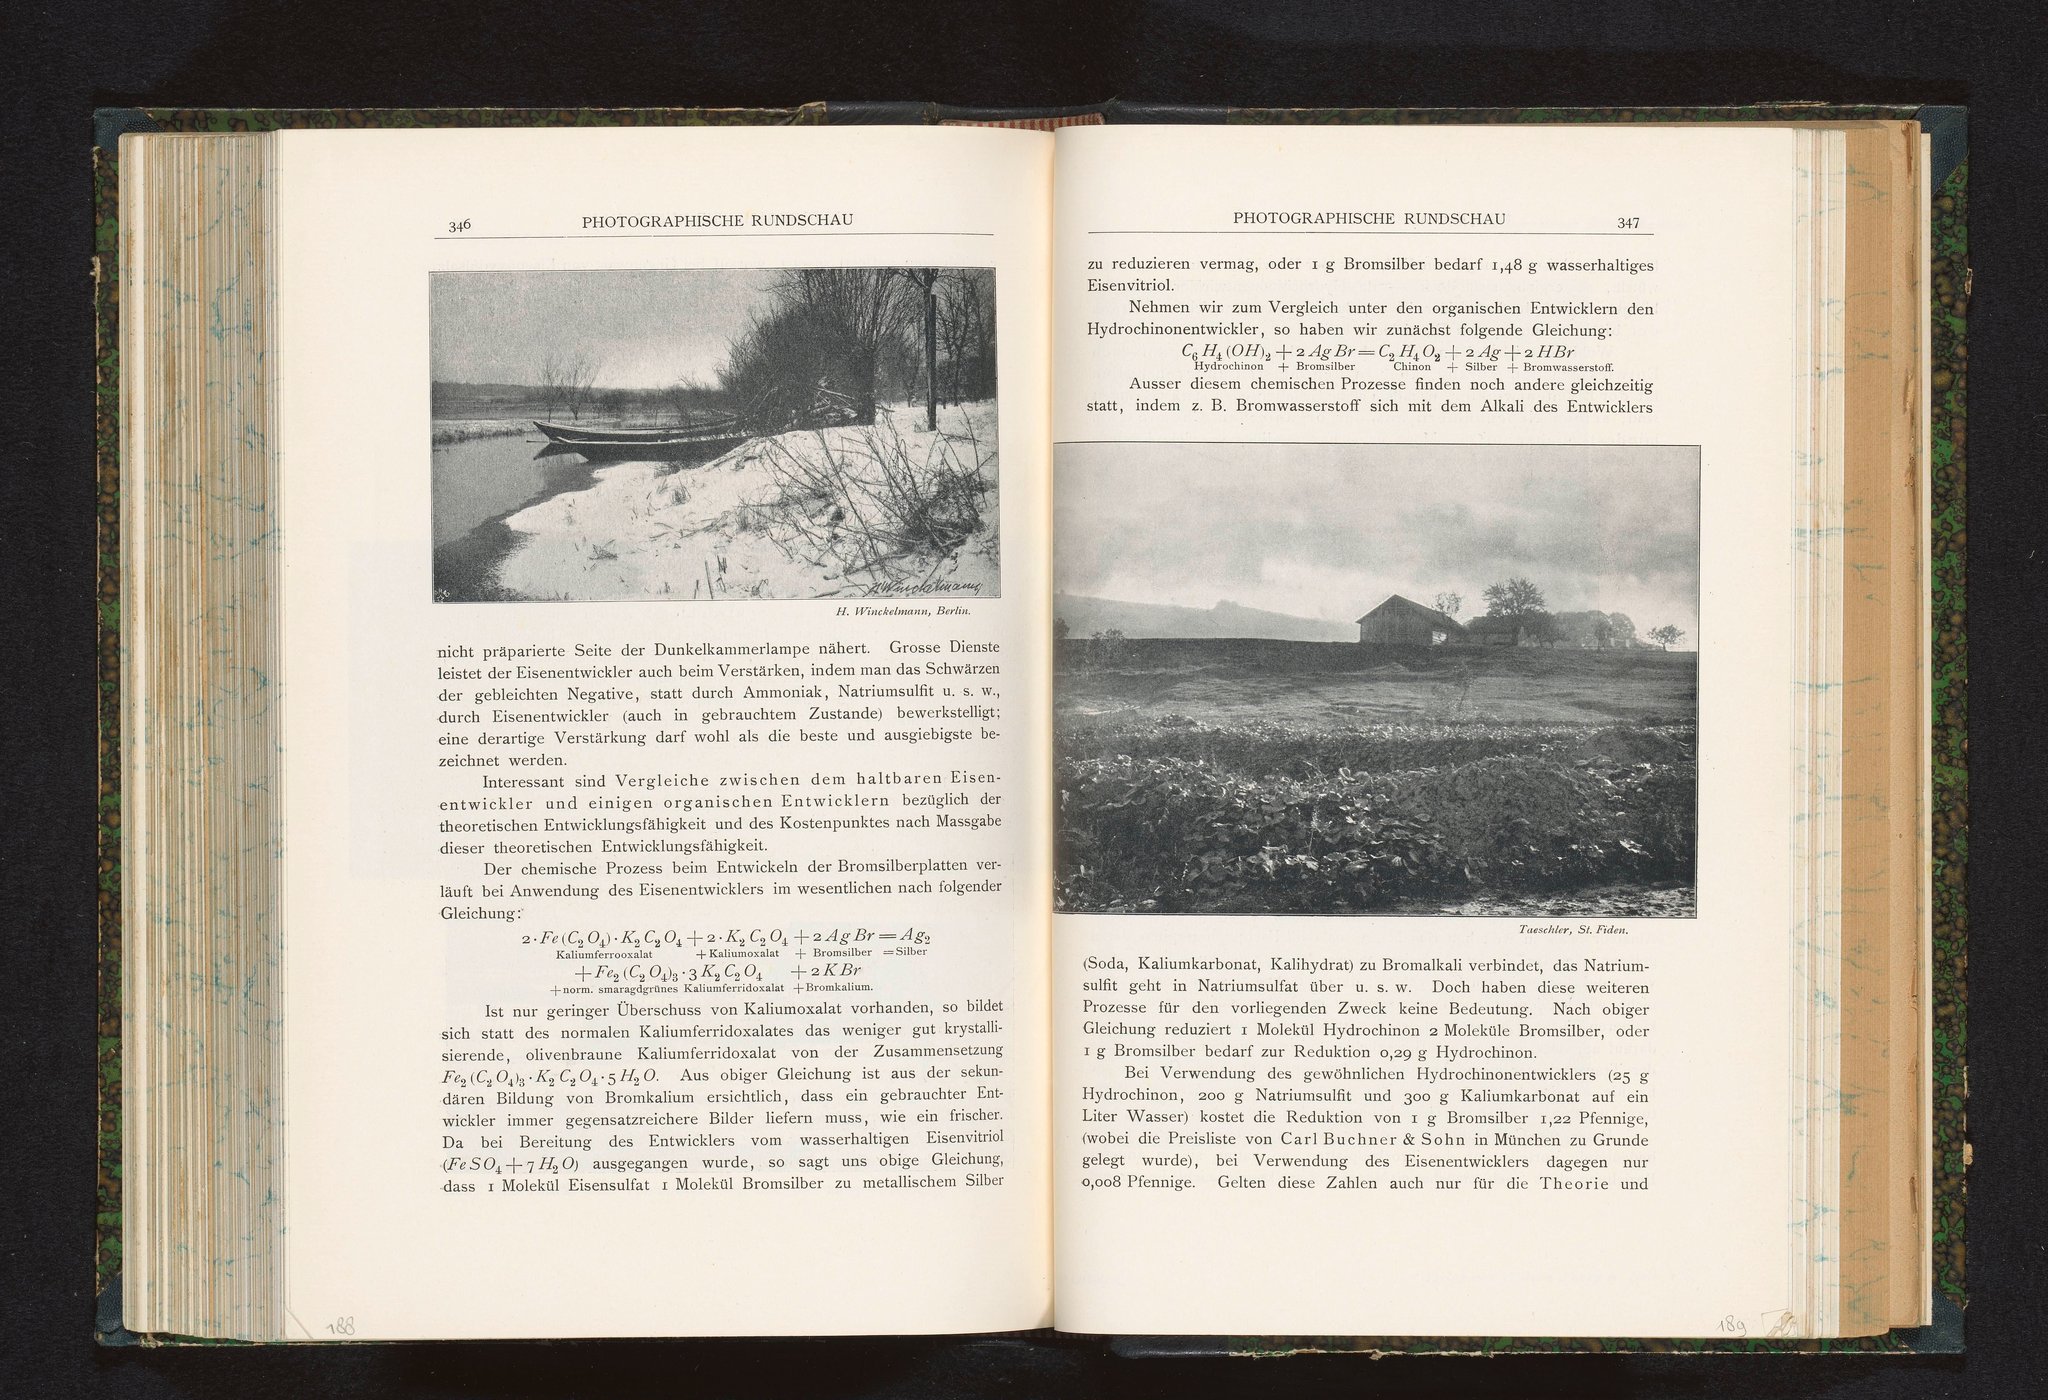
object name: page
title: Winters landschap met twee boten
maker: h. winckelmann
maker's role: fotograaf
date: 1894-1899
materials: paper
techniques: autotype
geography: berlin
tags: landscapes, rowing-boat, canoe, etc., snow